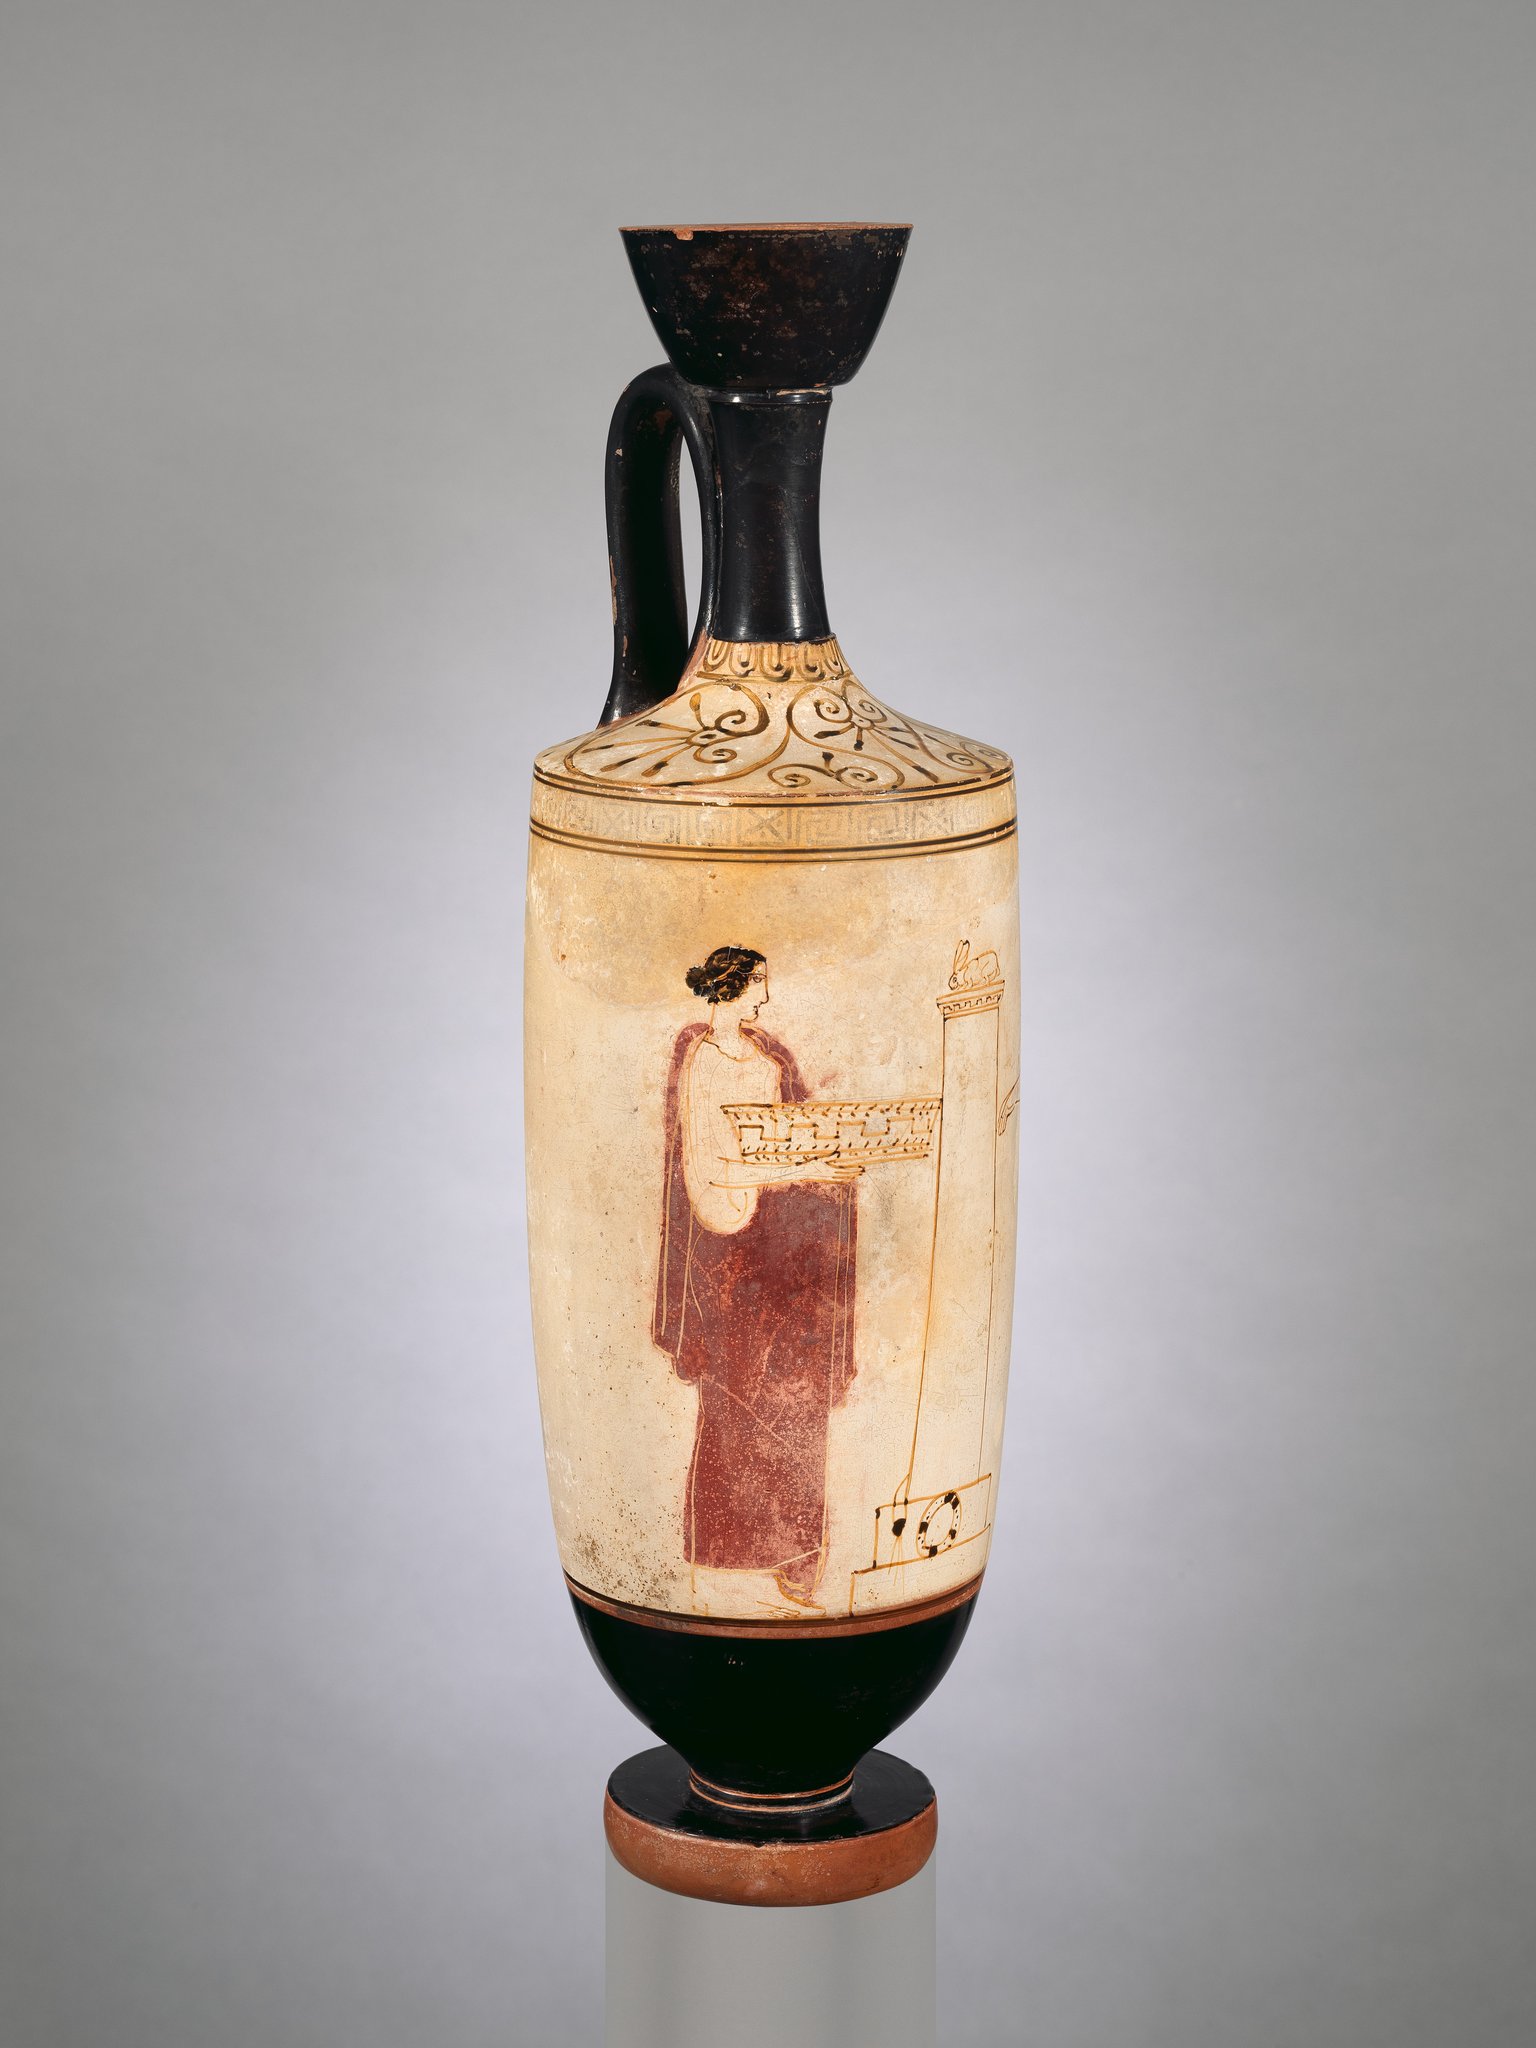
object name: lekythos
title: Terracotta lekythos (oil flask)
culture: greek, attic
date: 440-430 BCE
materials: terracotta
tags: tombs,women,rabbits